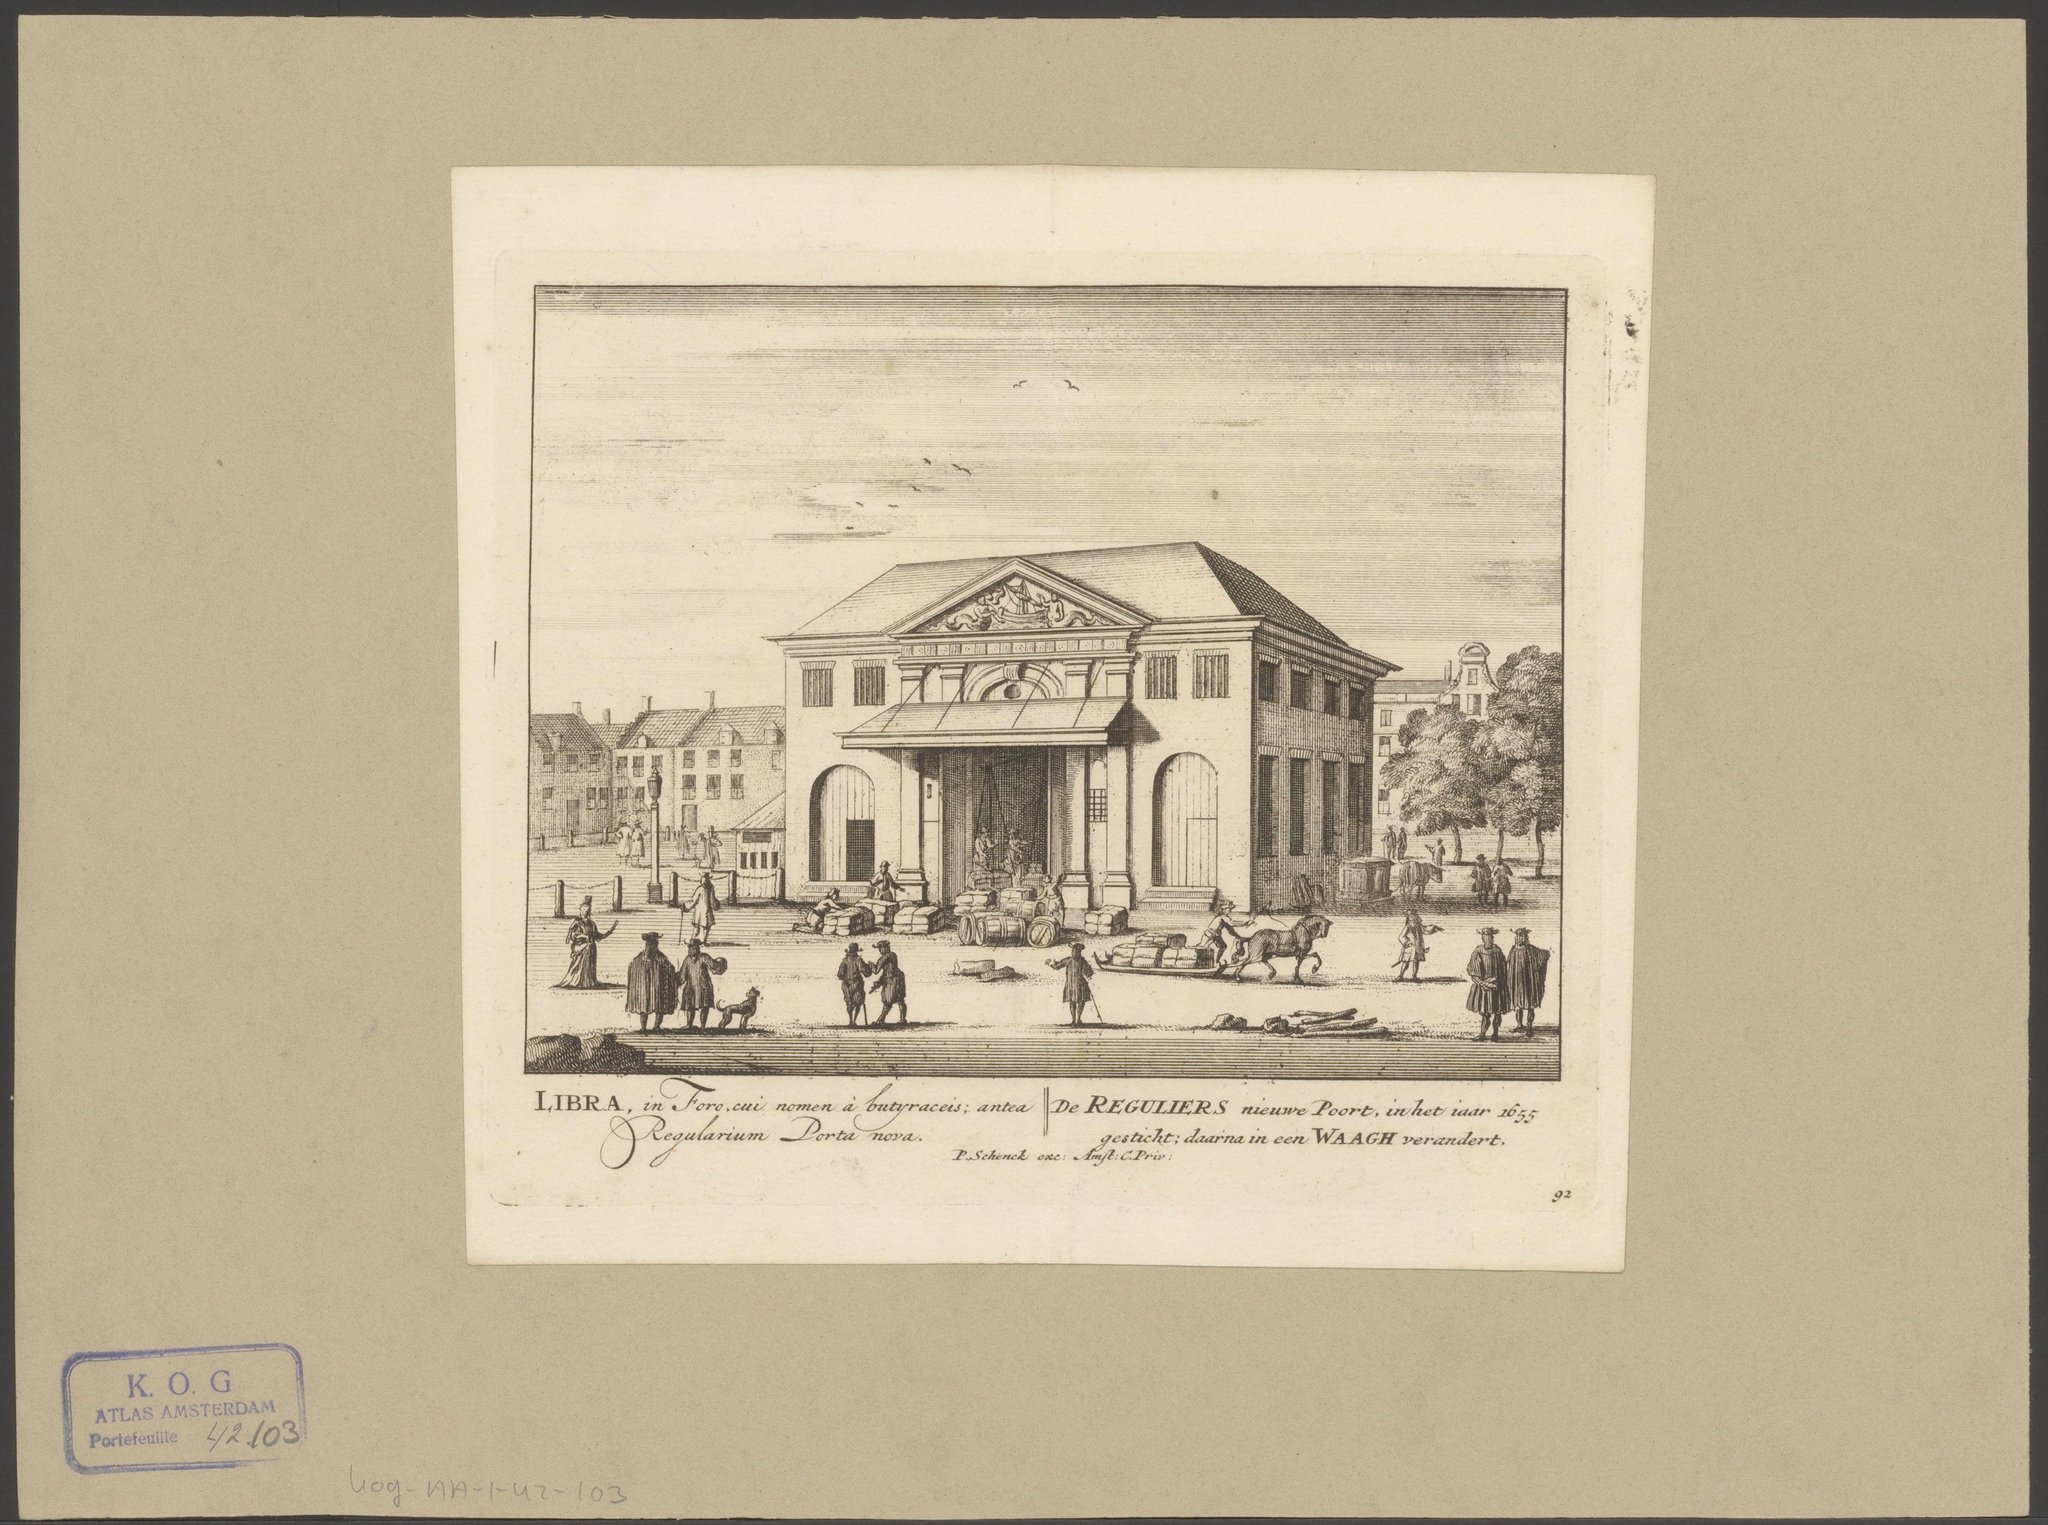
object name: print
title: Libra, in Foro, cui nomen à buytyraceis; antea Regularium Porta nova / De Reguliers nieuwe Poort, in het iaar 1655 gesticht; daarna in een Waagh verandert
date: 1710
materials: paper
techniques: engraving, etching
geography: amsterdam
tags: weigh-house, square, place, circus, etc. (+ city(-scape) with figures, staffage), amsterdam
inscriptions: collector's mark: Lugt 1461b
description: Prent mogelijk uit: Den Hoog-Edelgeboren Heer C. de Jonge van Ellemeet, Heere van Ellemeet (...). Amsterdam: Pieter Schenk I, 1710.